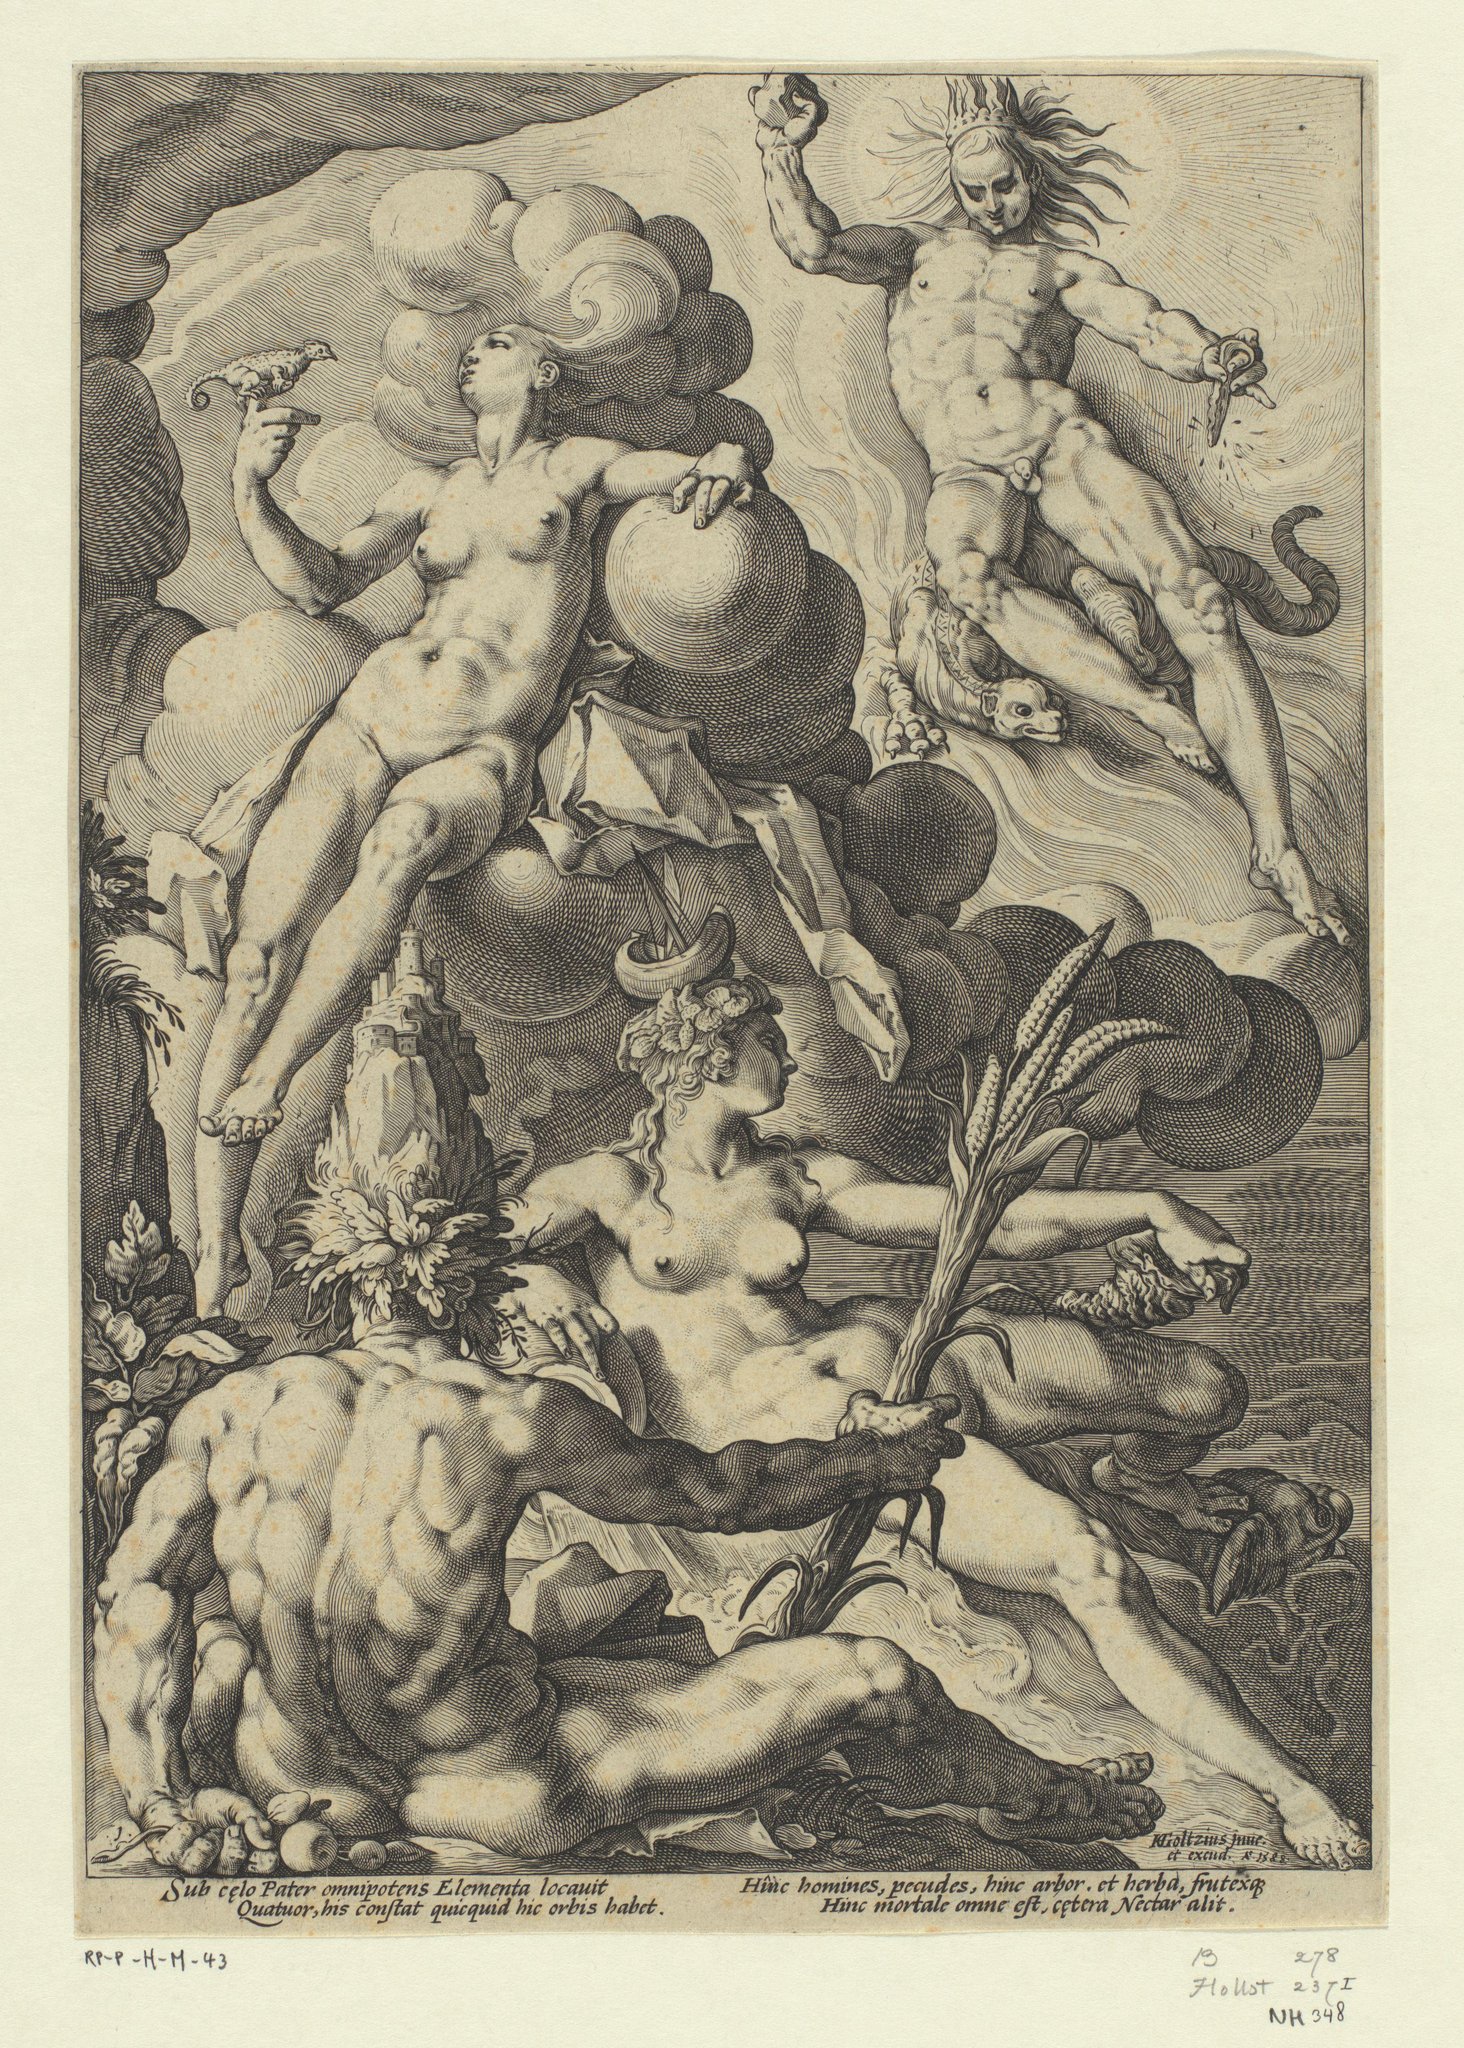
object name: print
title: Mythologische en allegorische voorstellingen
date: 1588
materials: paper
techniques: engraving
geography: haarlem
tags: the four elements, and ether, the fifth element (+ variant)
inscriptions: collector's mark: Lugt 10, collector's mark: Lugt 11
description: De vier elementen Aarde, Water, Lucht en Vuur, gepersonifieerd als twee vrouwelijke en twee mannelijke figuren. Links op de voorgrond, op de rug gezien, zit Aarde (Terra) met in zijn hand korenschoven. Tevens op de voorgrond zit Water (Aqua) als vrouwenfiguur met op haar hoofd een schip en naast haar een stroom. In de lucht tussen de wolken zit Lucht (Aer) met op haar hand een kameleon. Rechtsachter een mannenfiguur dat Vuur (Ignis) verbeeldt, zittend op een draak en op zijn hoofd een kroon van vlammen. Achter zijn hoofd de zon.